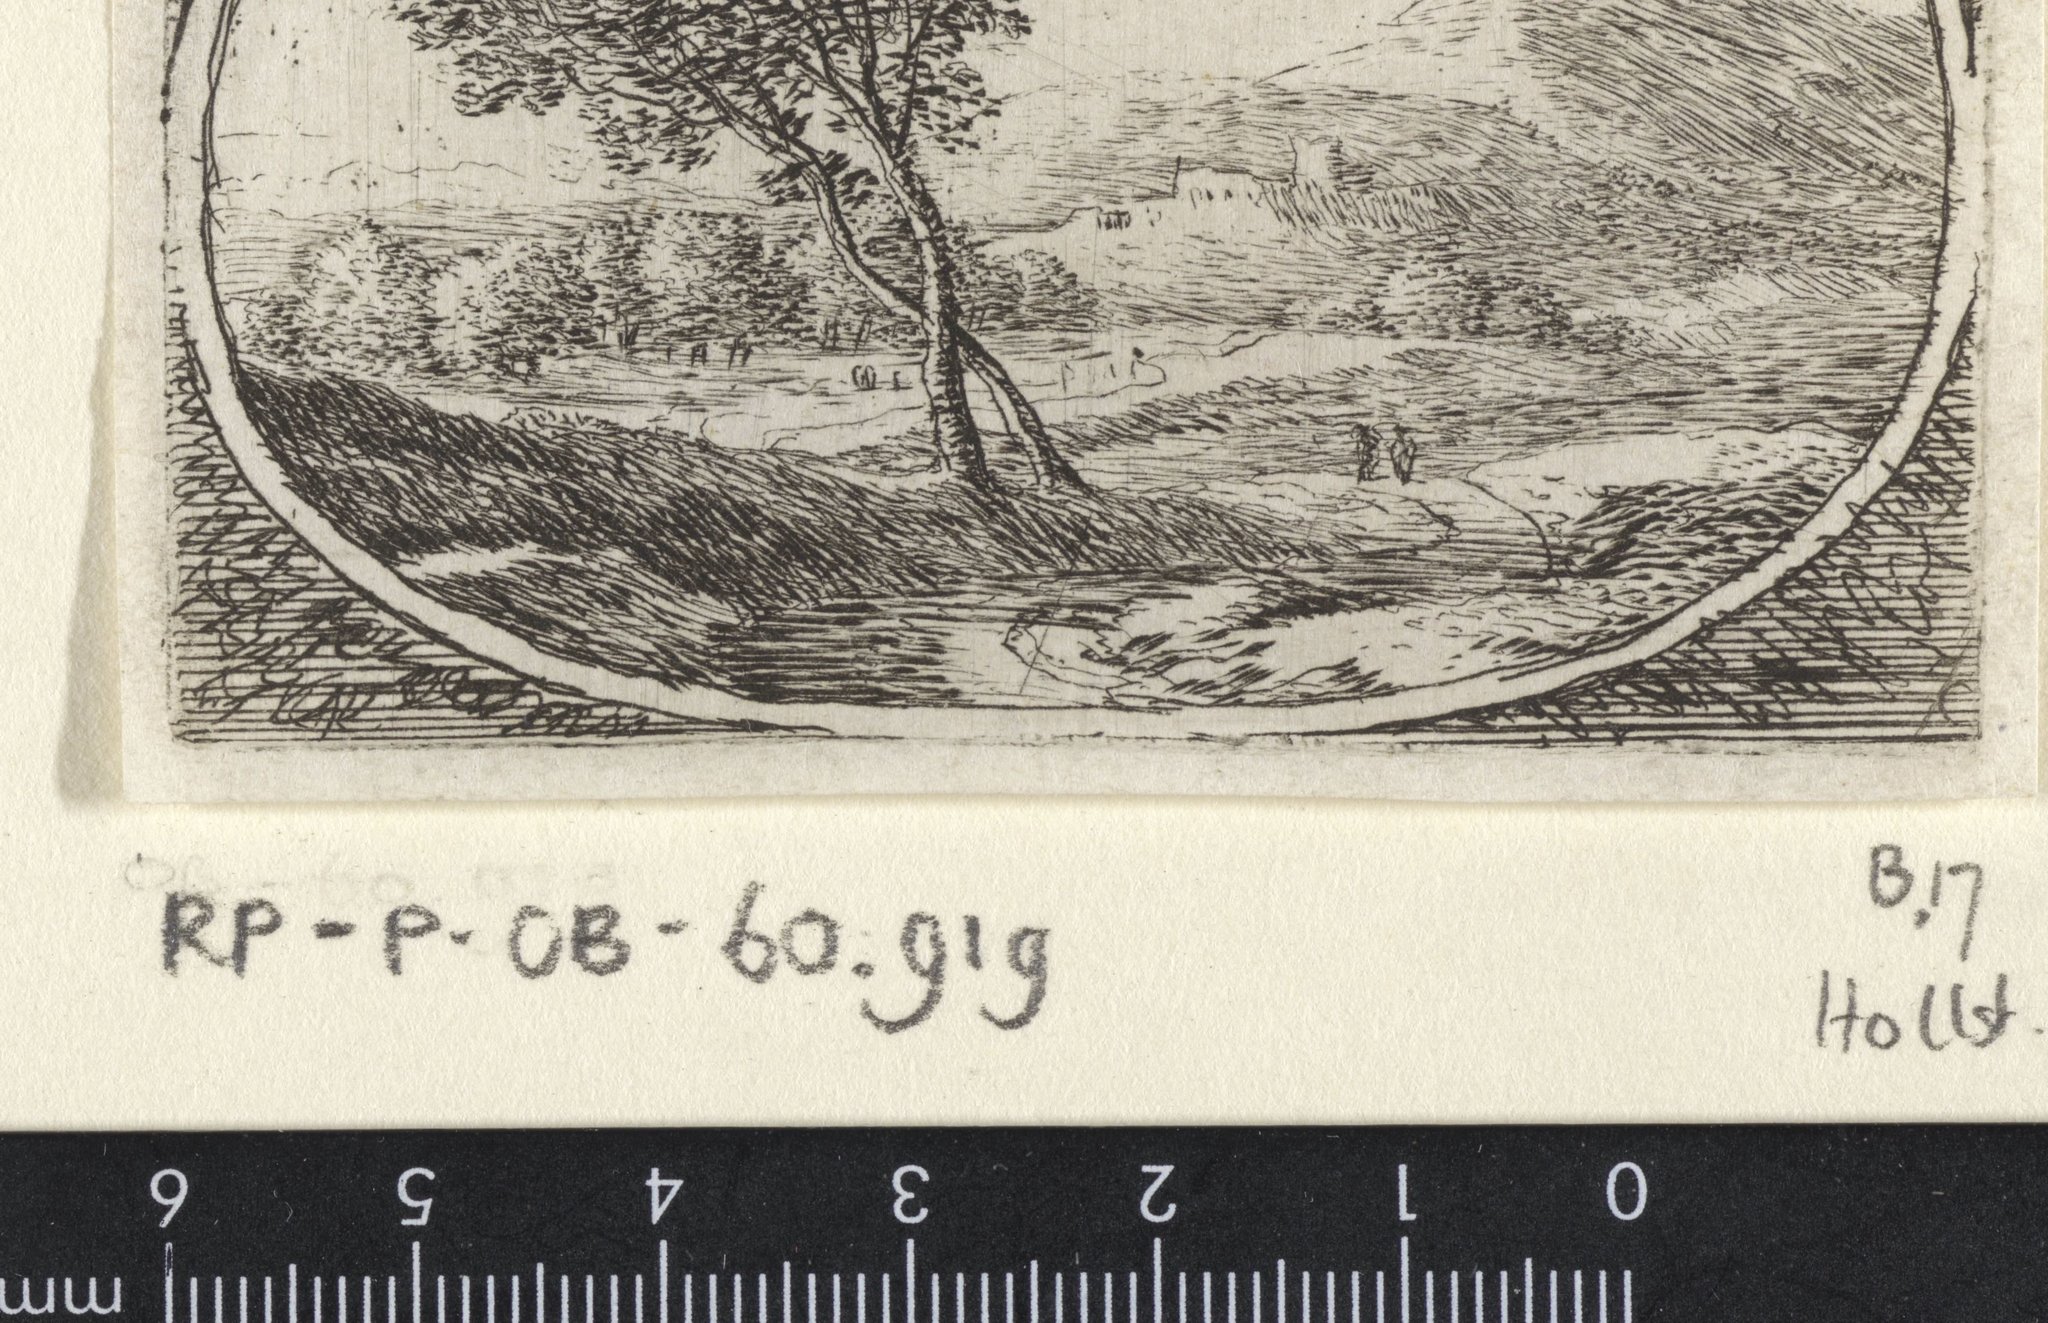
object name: print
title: Ovale fantasielandschappen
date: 1650-1655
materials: paper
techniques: etching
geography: paris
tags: landscapes, rural housing, e.g. country-house, villa, cottage, (high) hill, 'en route', traveller under way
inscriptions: collector's mark: Lugt 240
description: In een ovale omlijsting lopen enkele figuren op een pad langs twee bomen waarvan de stammen elkaar kruisen. In de verte ligt een gebouw in de heuvels.